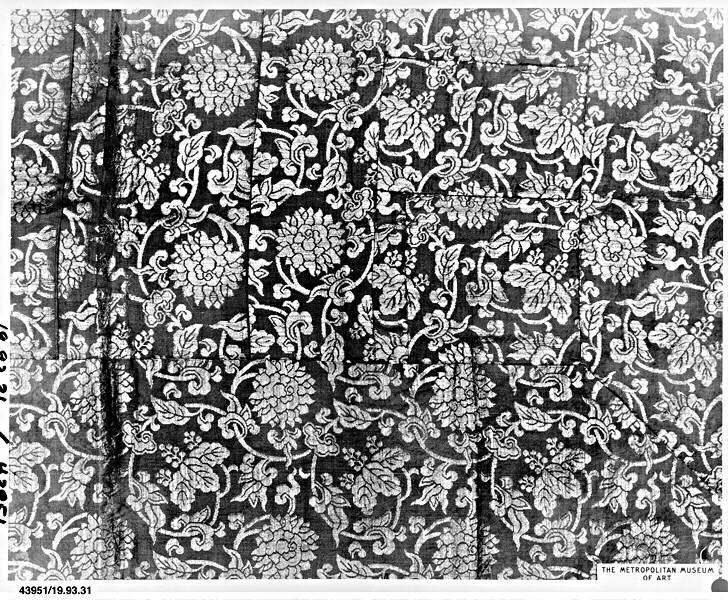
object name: robe, priest's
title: Priest's Robe (Shichijō)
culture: japanese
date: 1596-1615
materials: metal thread, silk